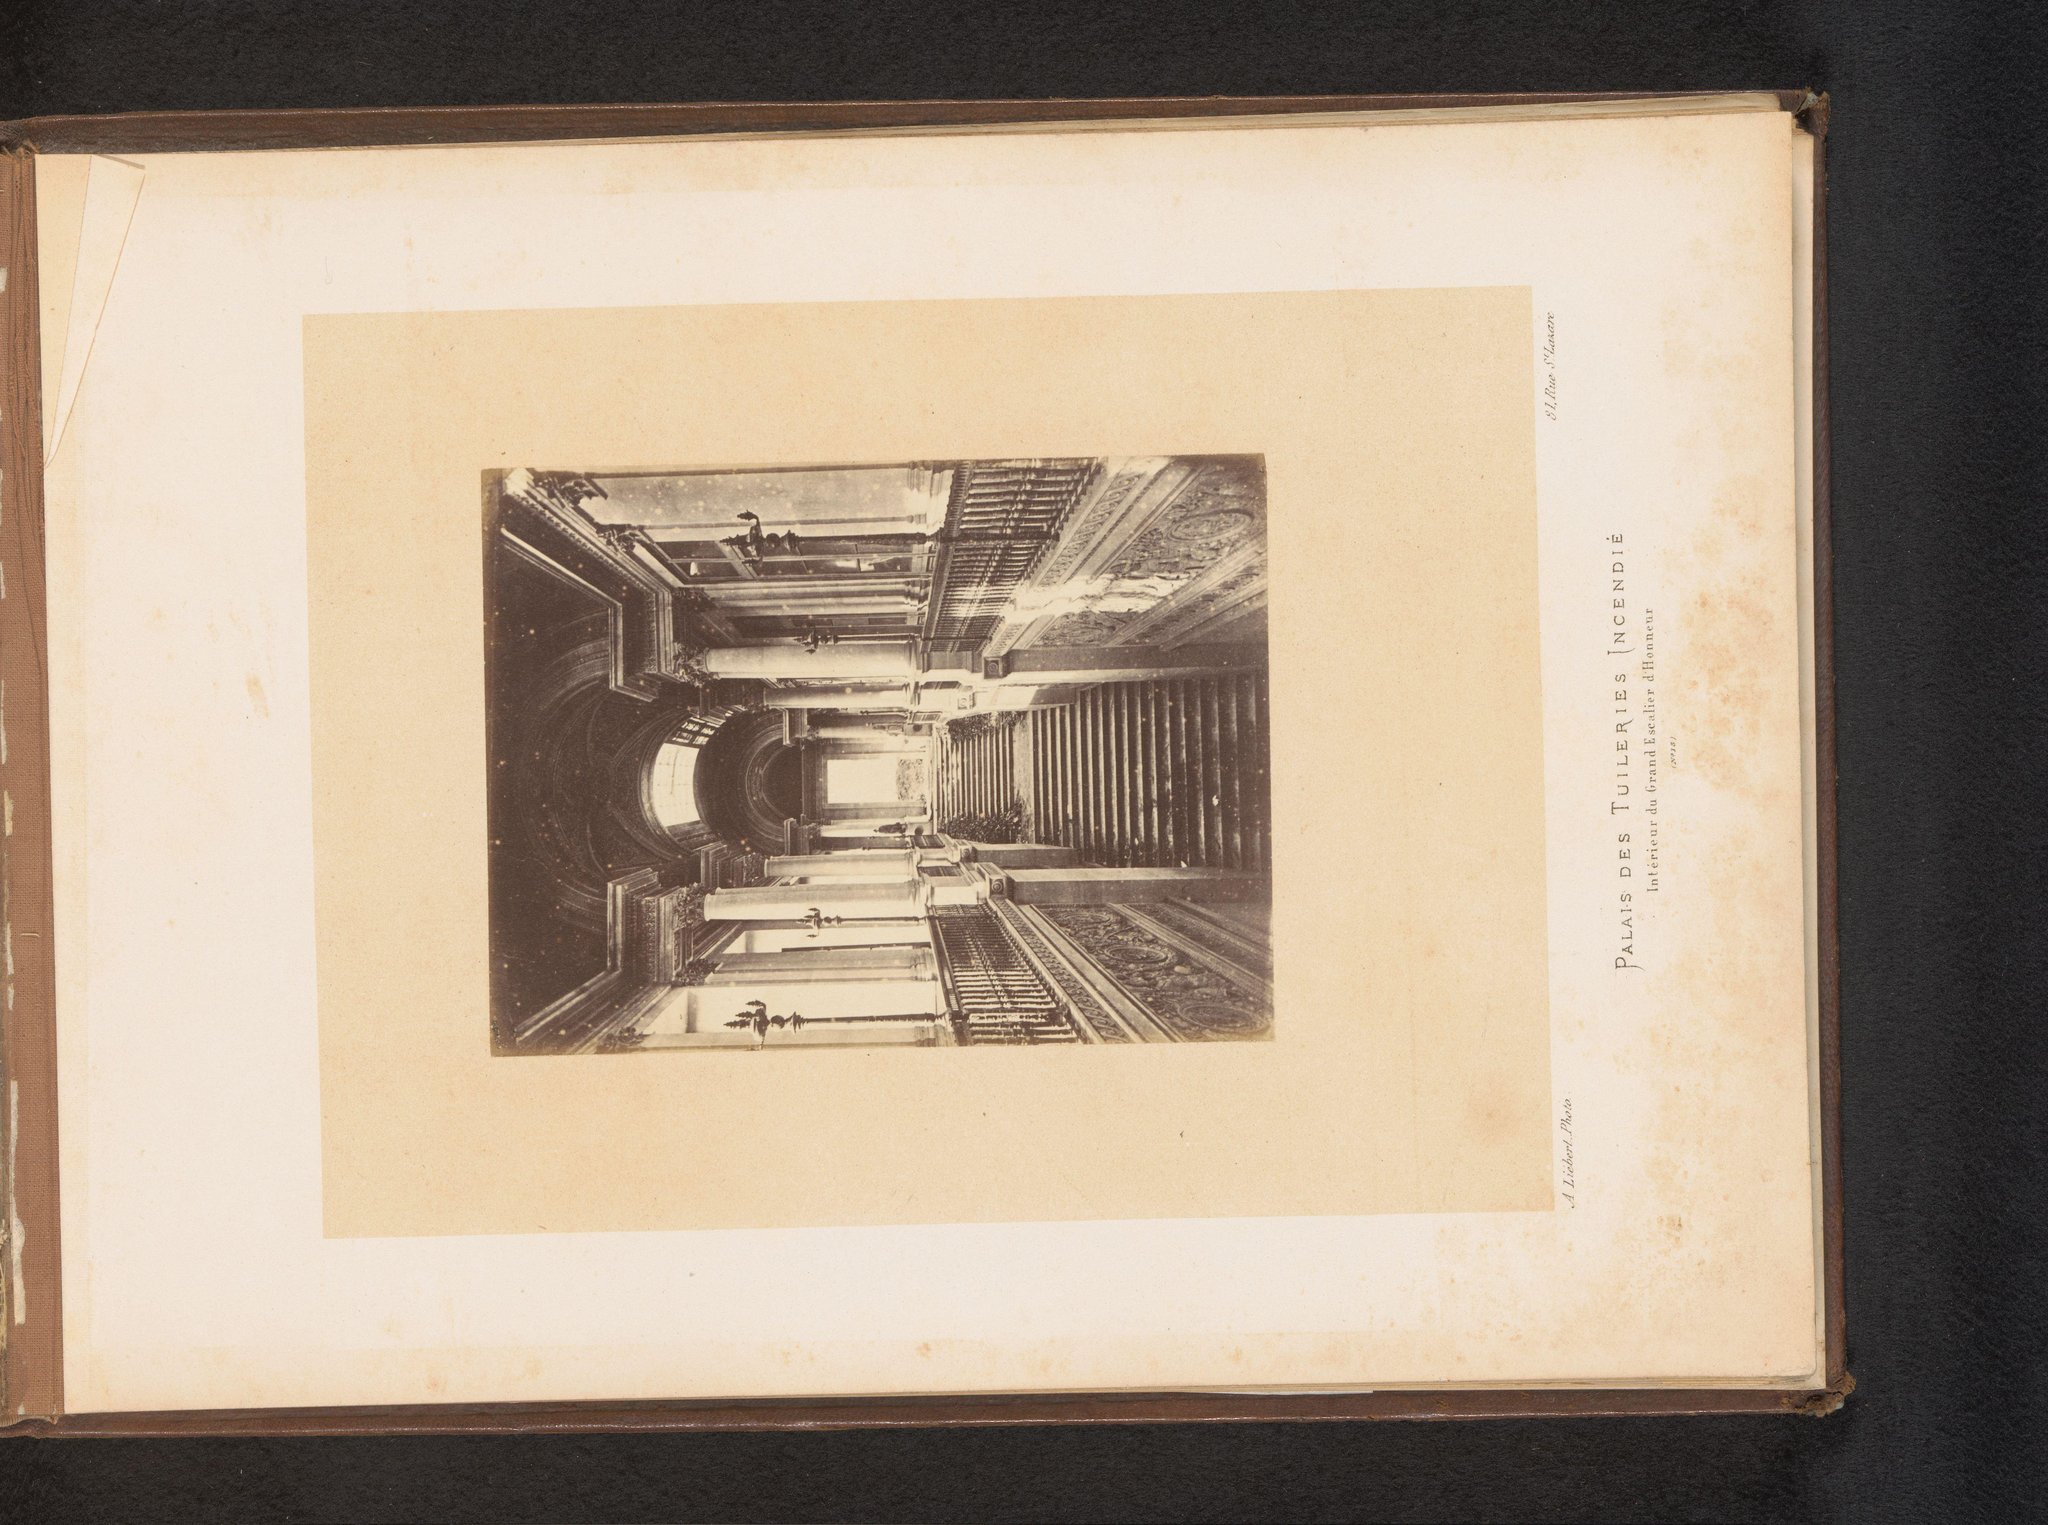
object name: page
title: Palais des Tuileries Incendié. Intérieur du Grand Escalier d'Honneur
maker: alphonse-justin liébert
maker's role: fotograaf, marinier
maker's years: 1827-1914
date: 1871-1872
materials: photographic support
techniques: albumen print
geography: paris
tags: stairwell, ruin of a building ~ architecture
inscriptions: address: ‘31, Rue St. Lazare’, number: ‘(No. 13)’